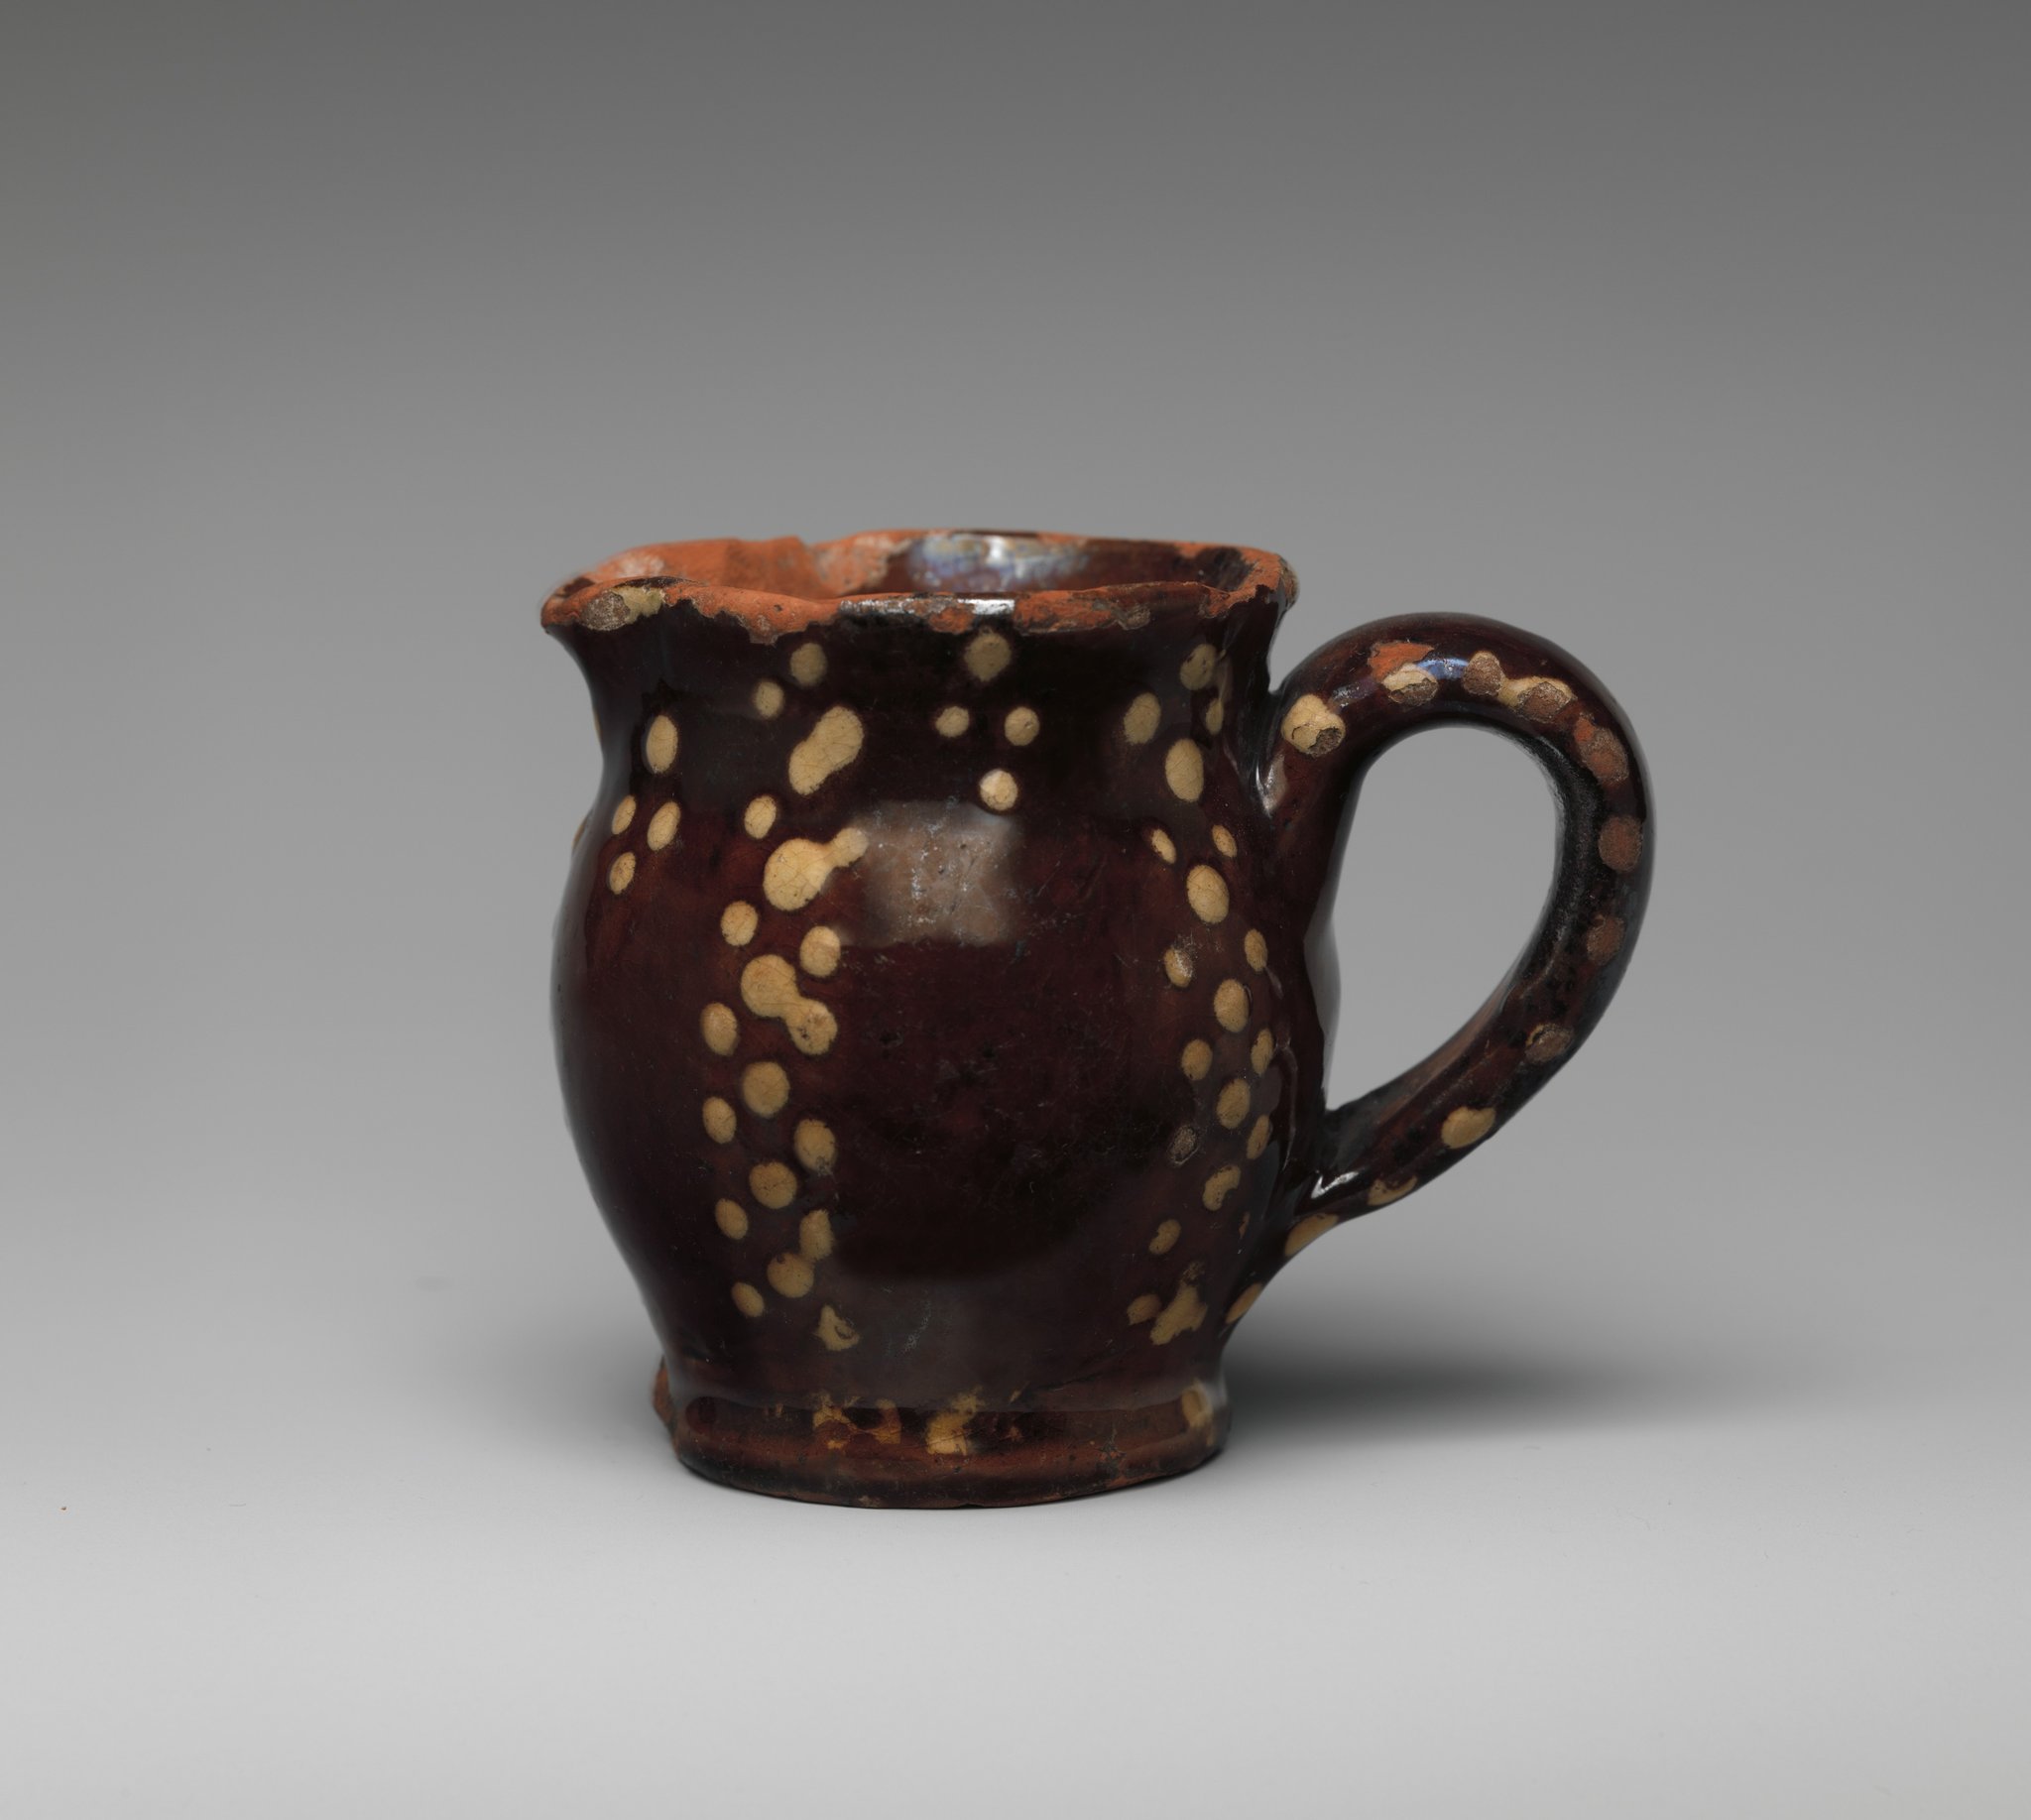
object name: pitcher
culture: american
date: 1800-1830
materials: earthenware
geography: united states